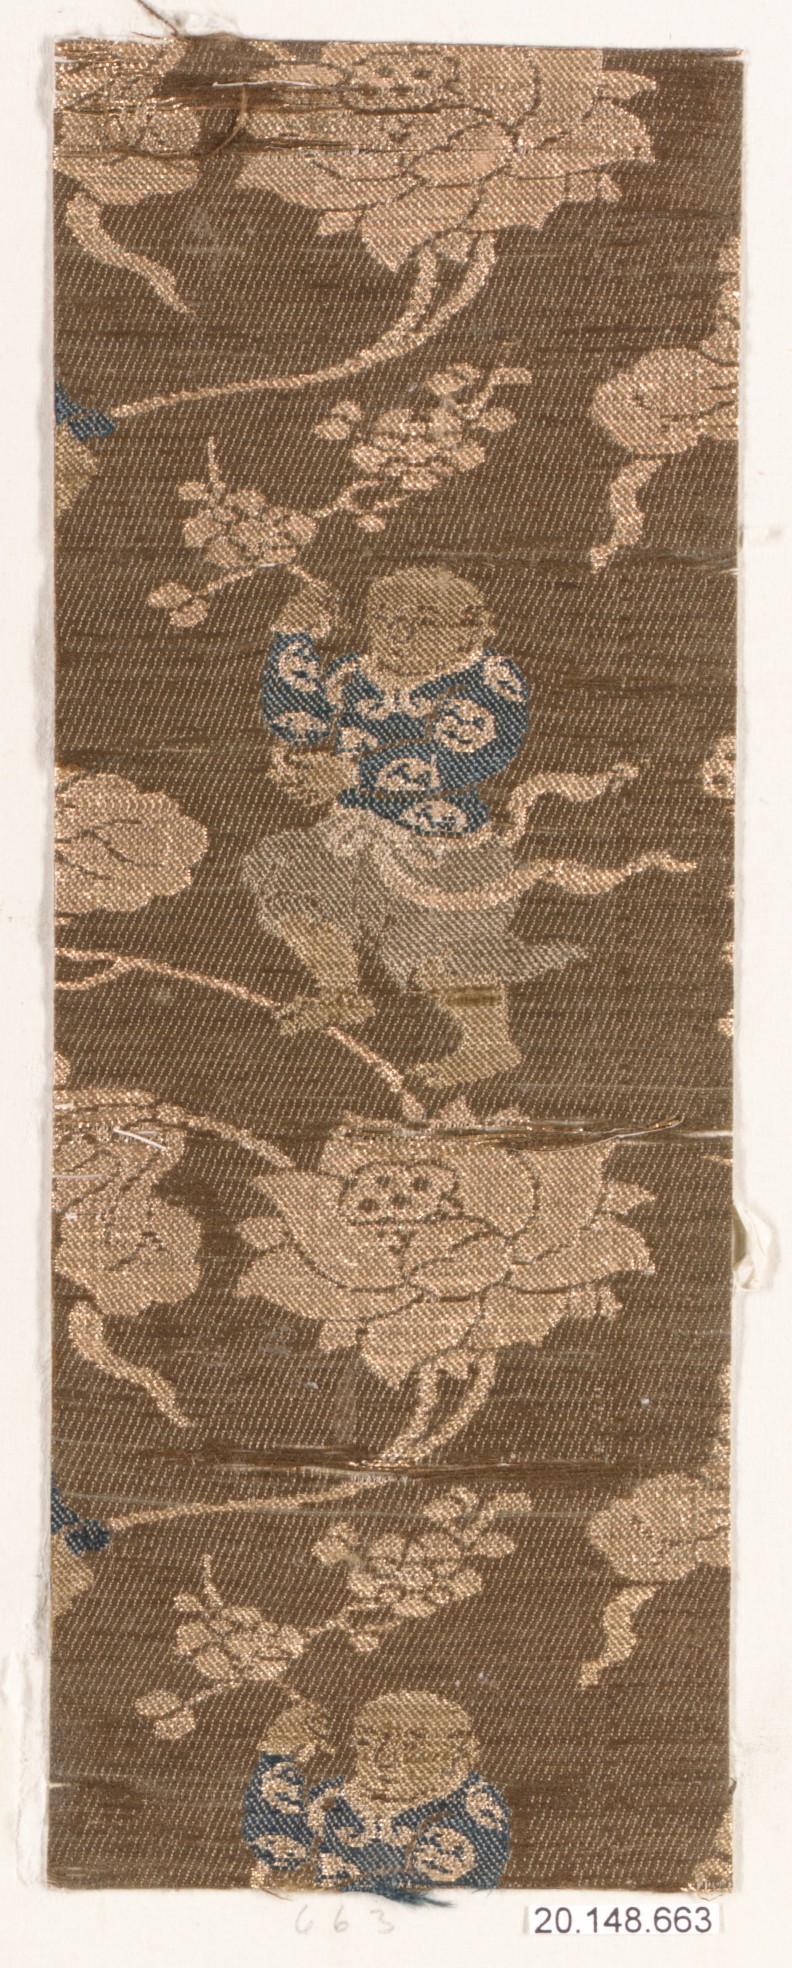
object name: piece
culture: japanese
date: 1701-1800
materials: silk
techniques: compound weave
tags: men,flowers